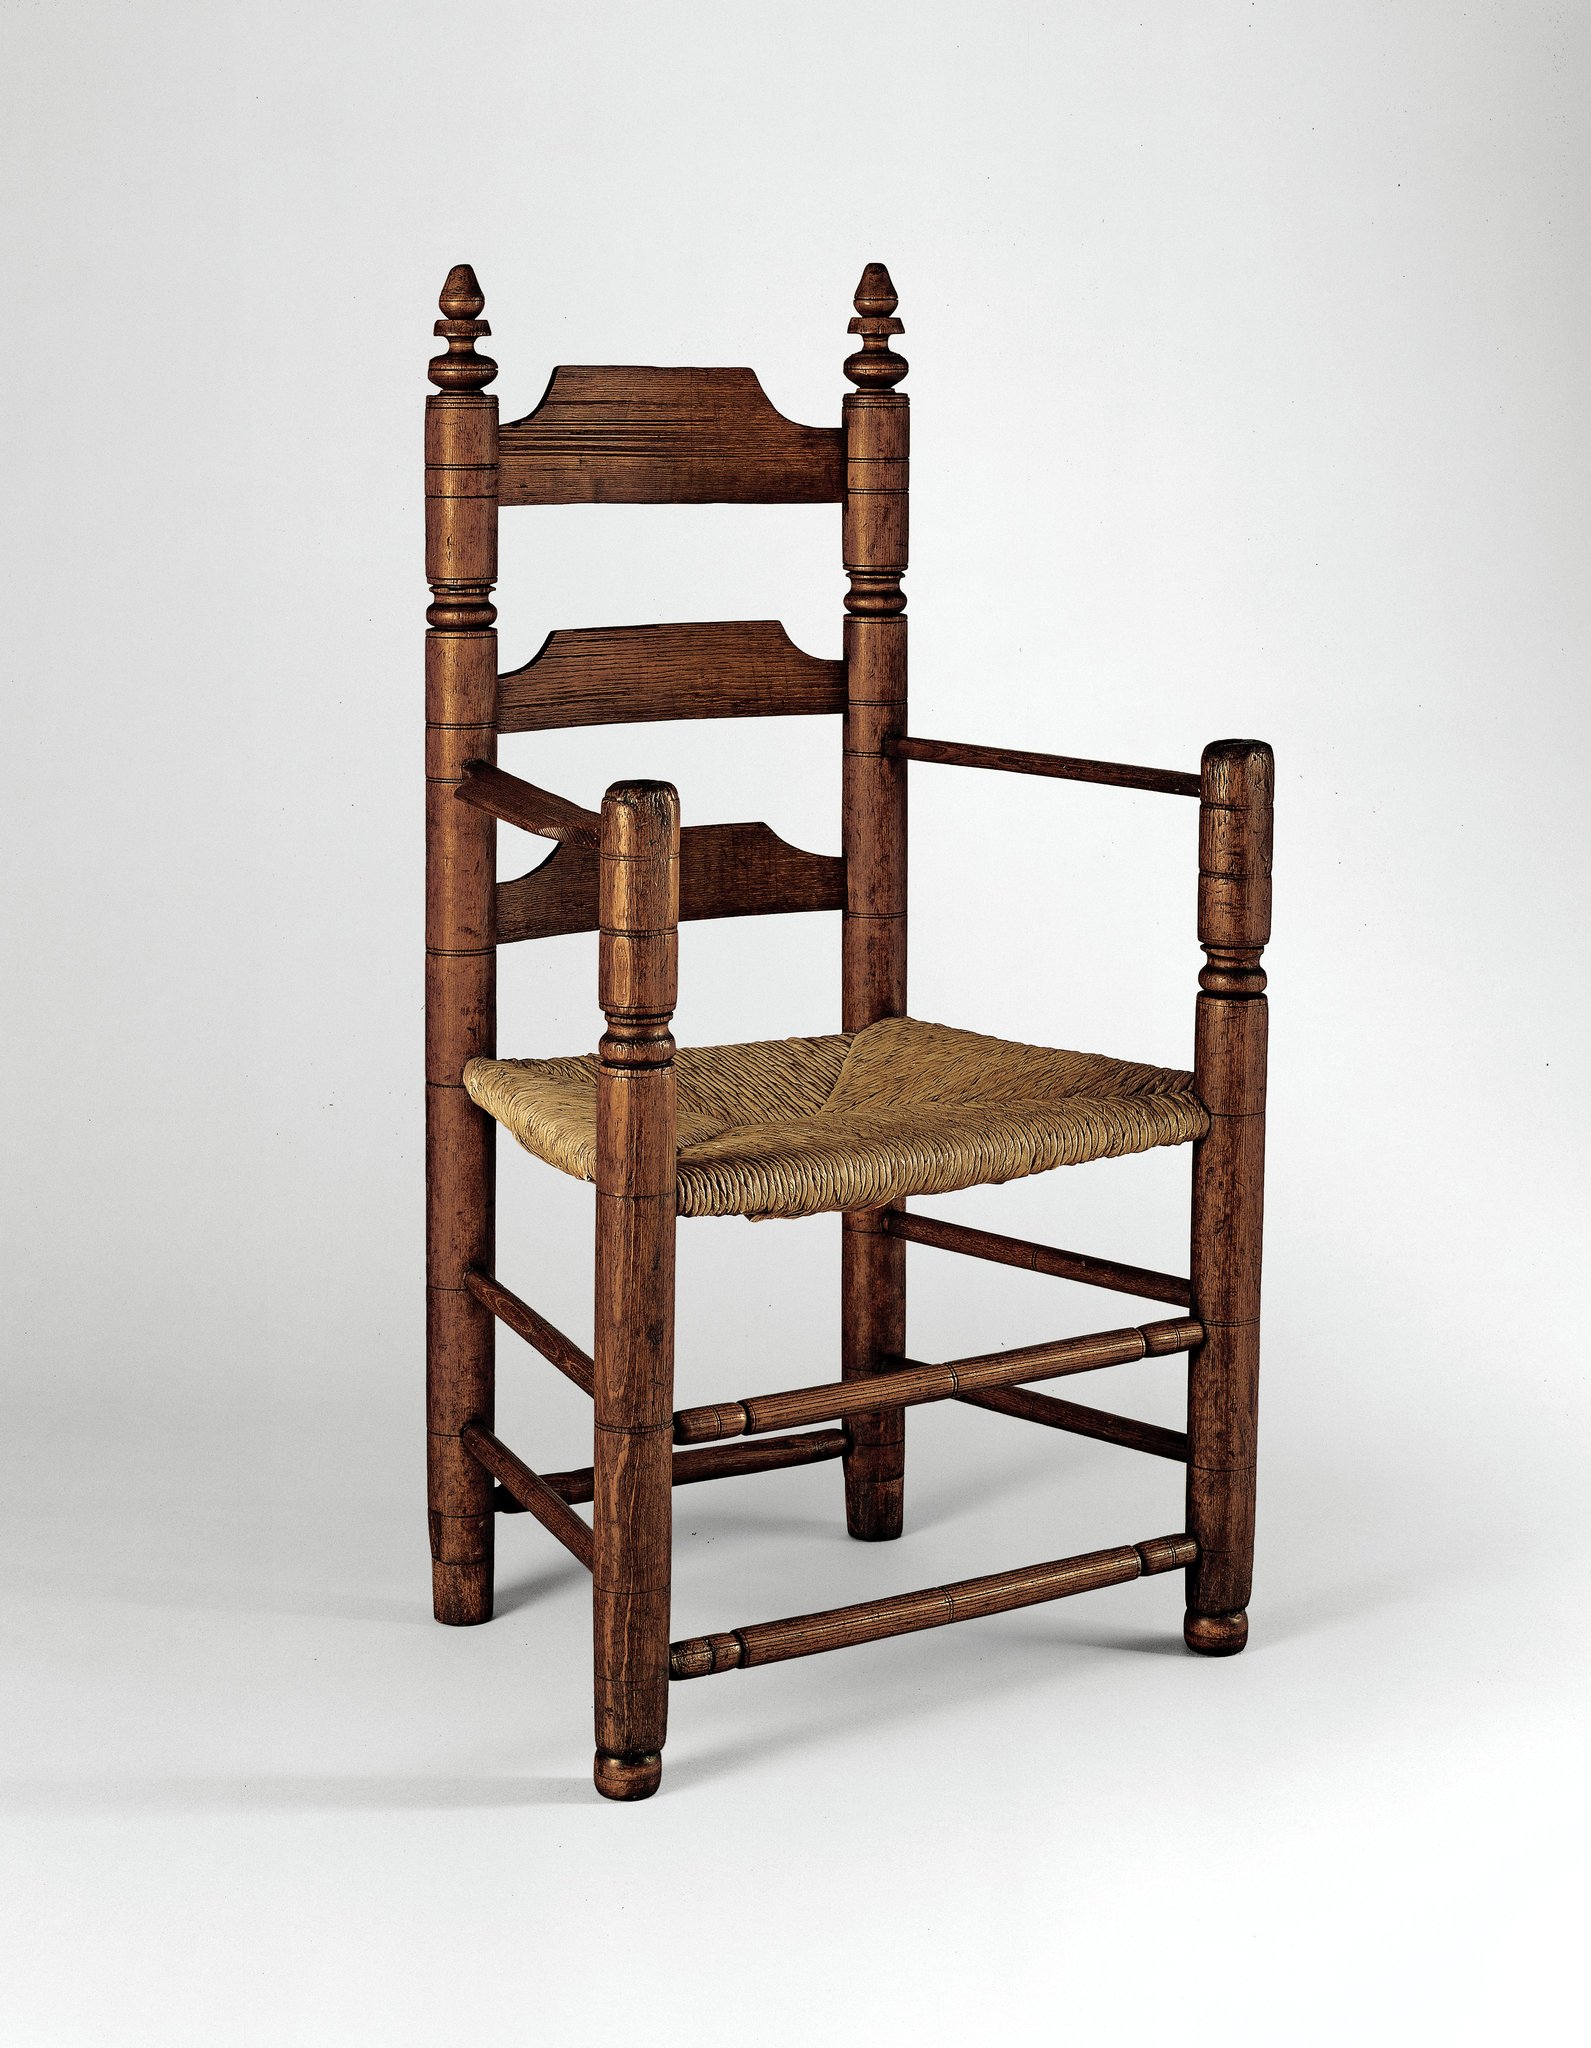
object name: slat back armchair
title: Slat-back armchair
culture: american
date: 1650-1690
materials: wood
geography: united states